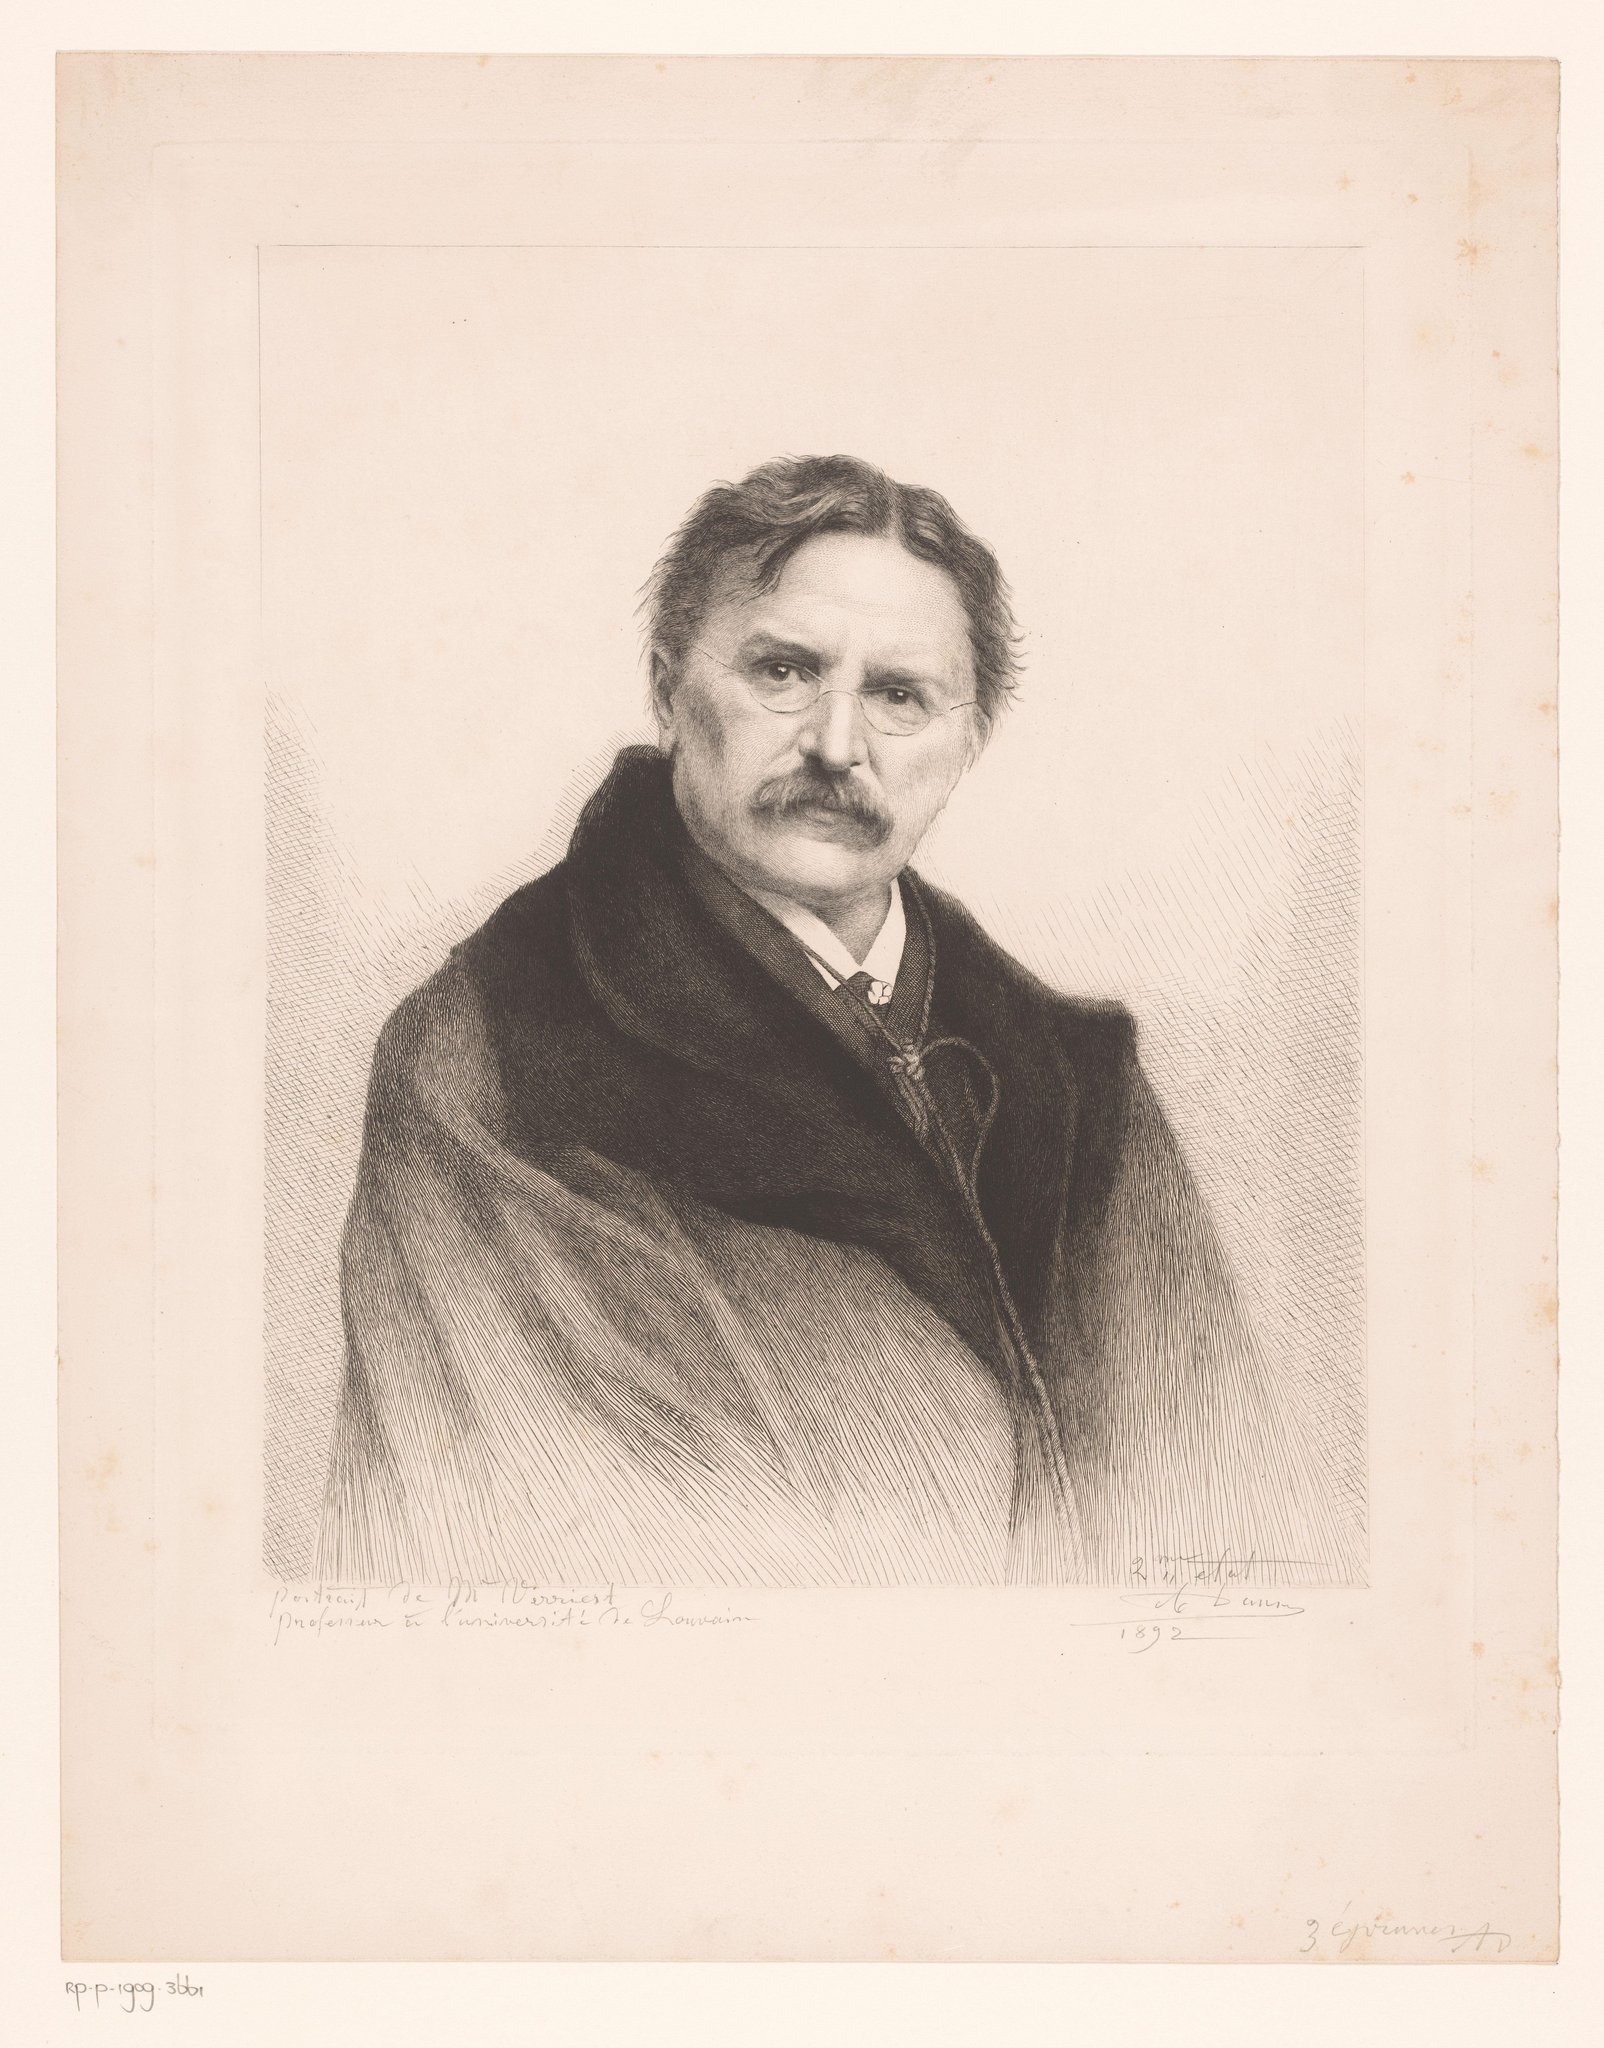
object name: print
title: Portret van Gustaaf Verriest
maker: auguste danse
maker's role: print maker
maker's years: 1829-1929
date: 1892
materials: paper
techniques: drypoint, etching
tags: historical person (...) - historical person (...) portrayed alone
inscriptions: annotation: ‘2me etat; 3 épreuves’, collector's mark: Lugt 2228